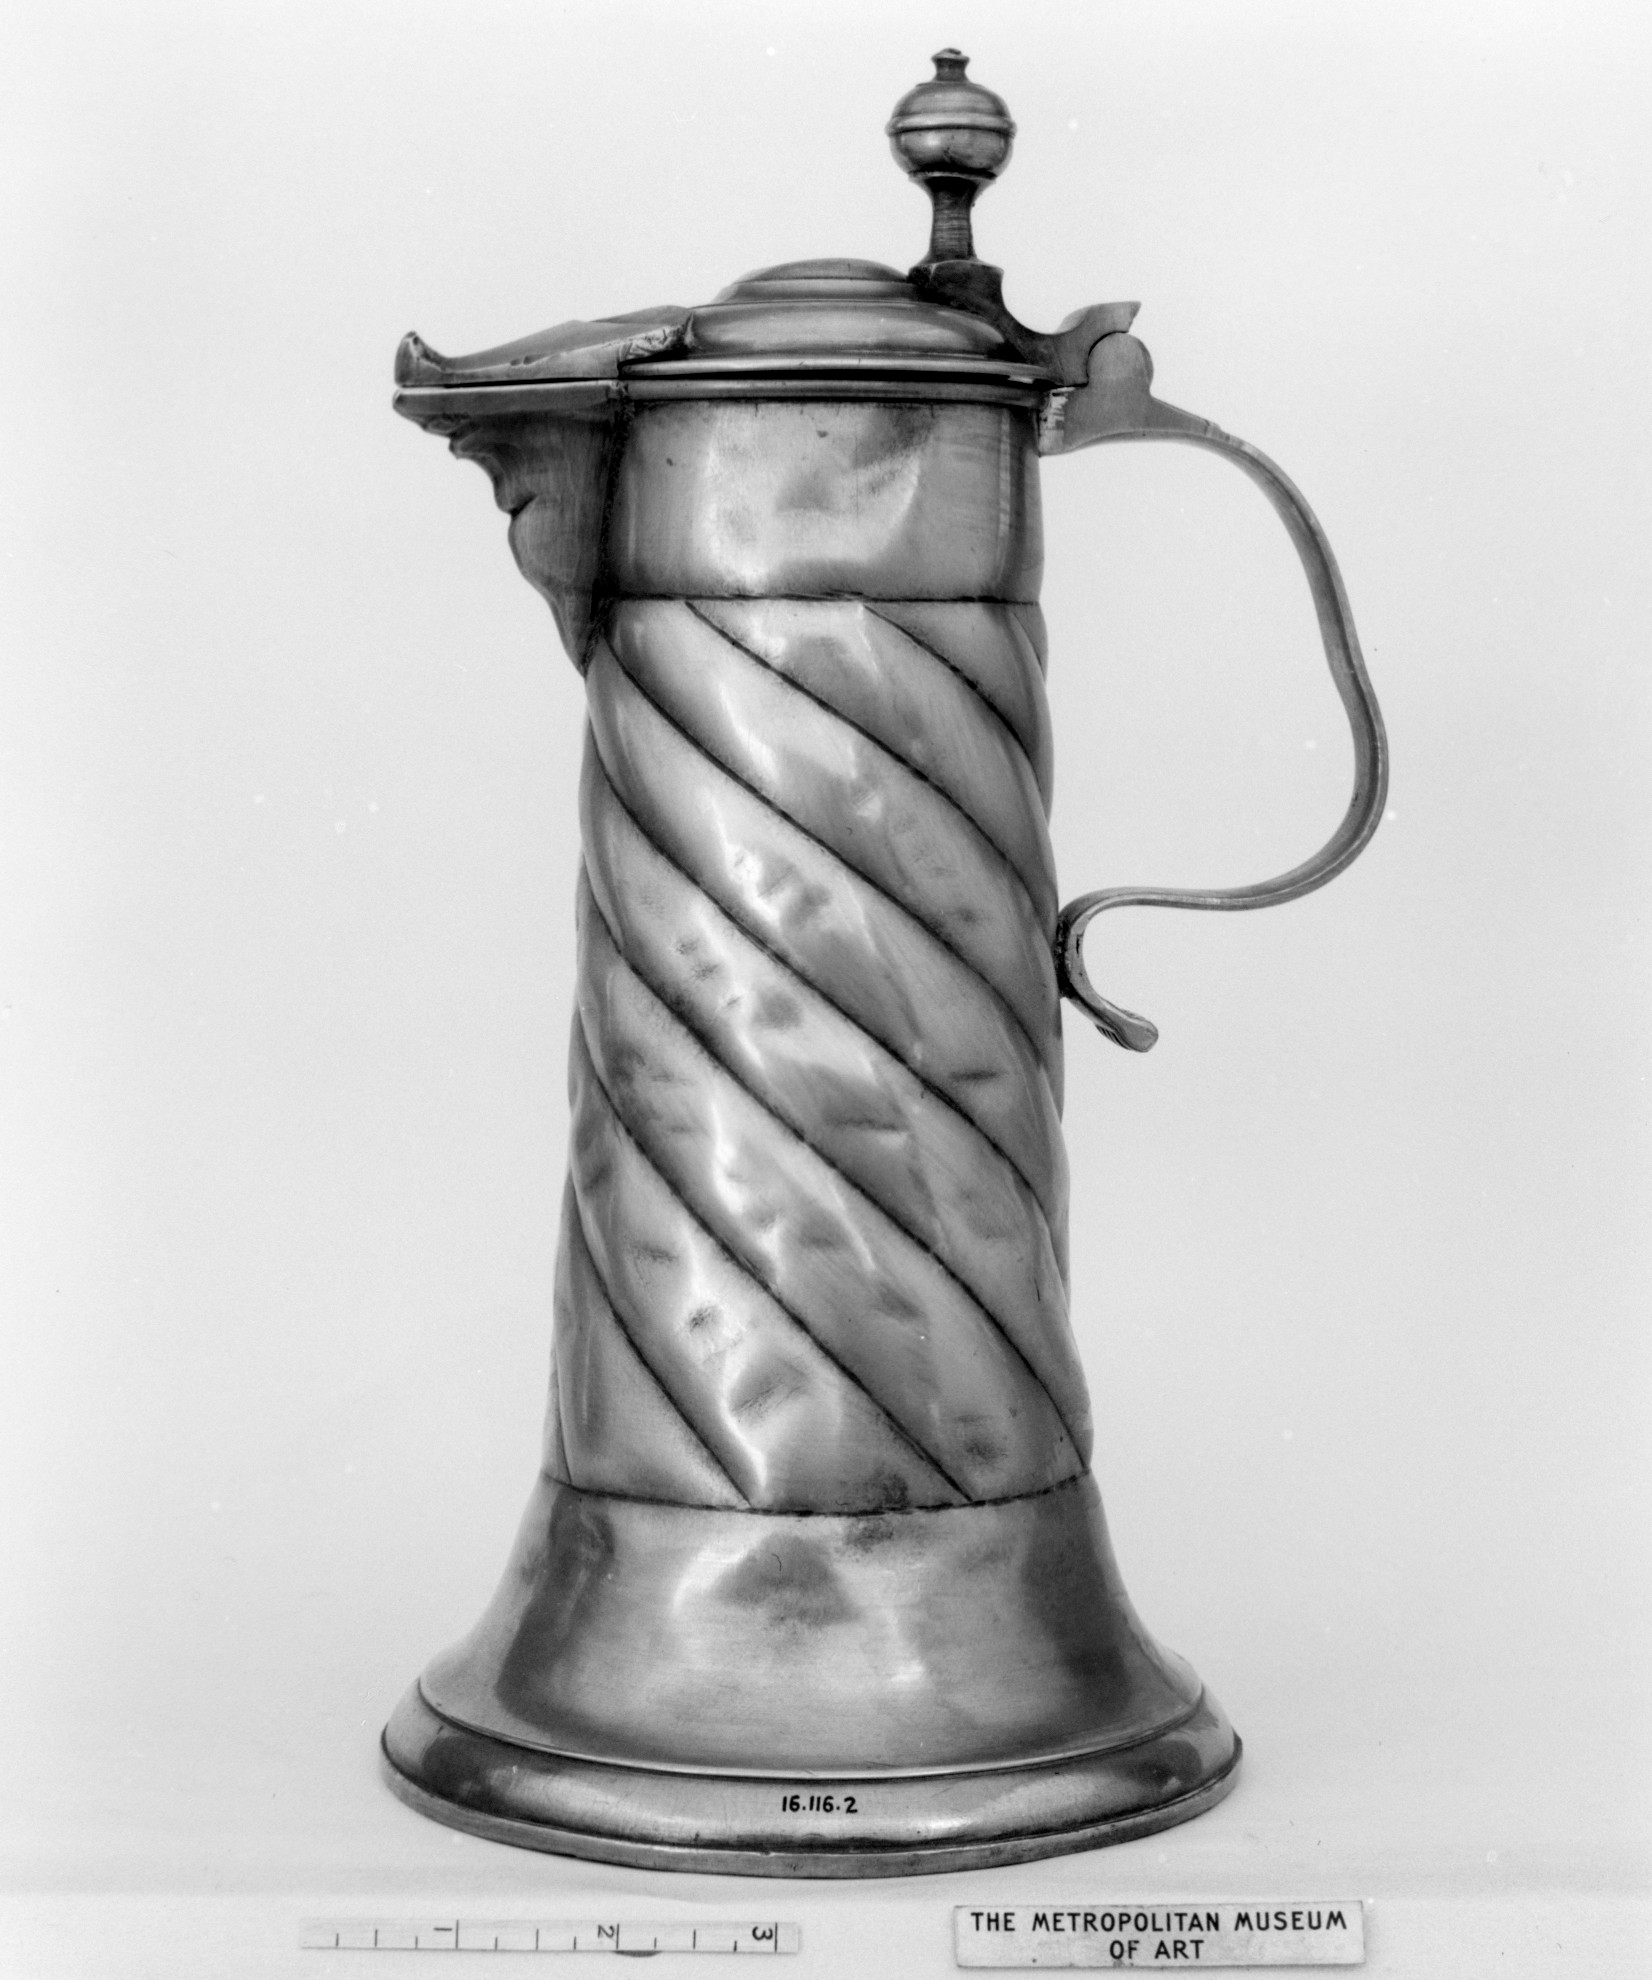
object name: tankard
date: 1701-1800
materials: pewter